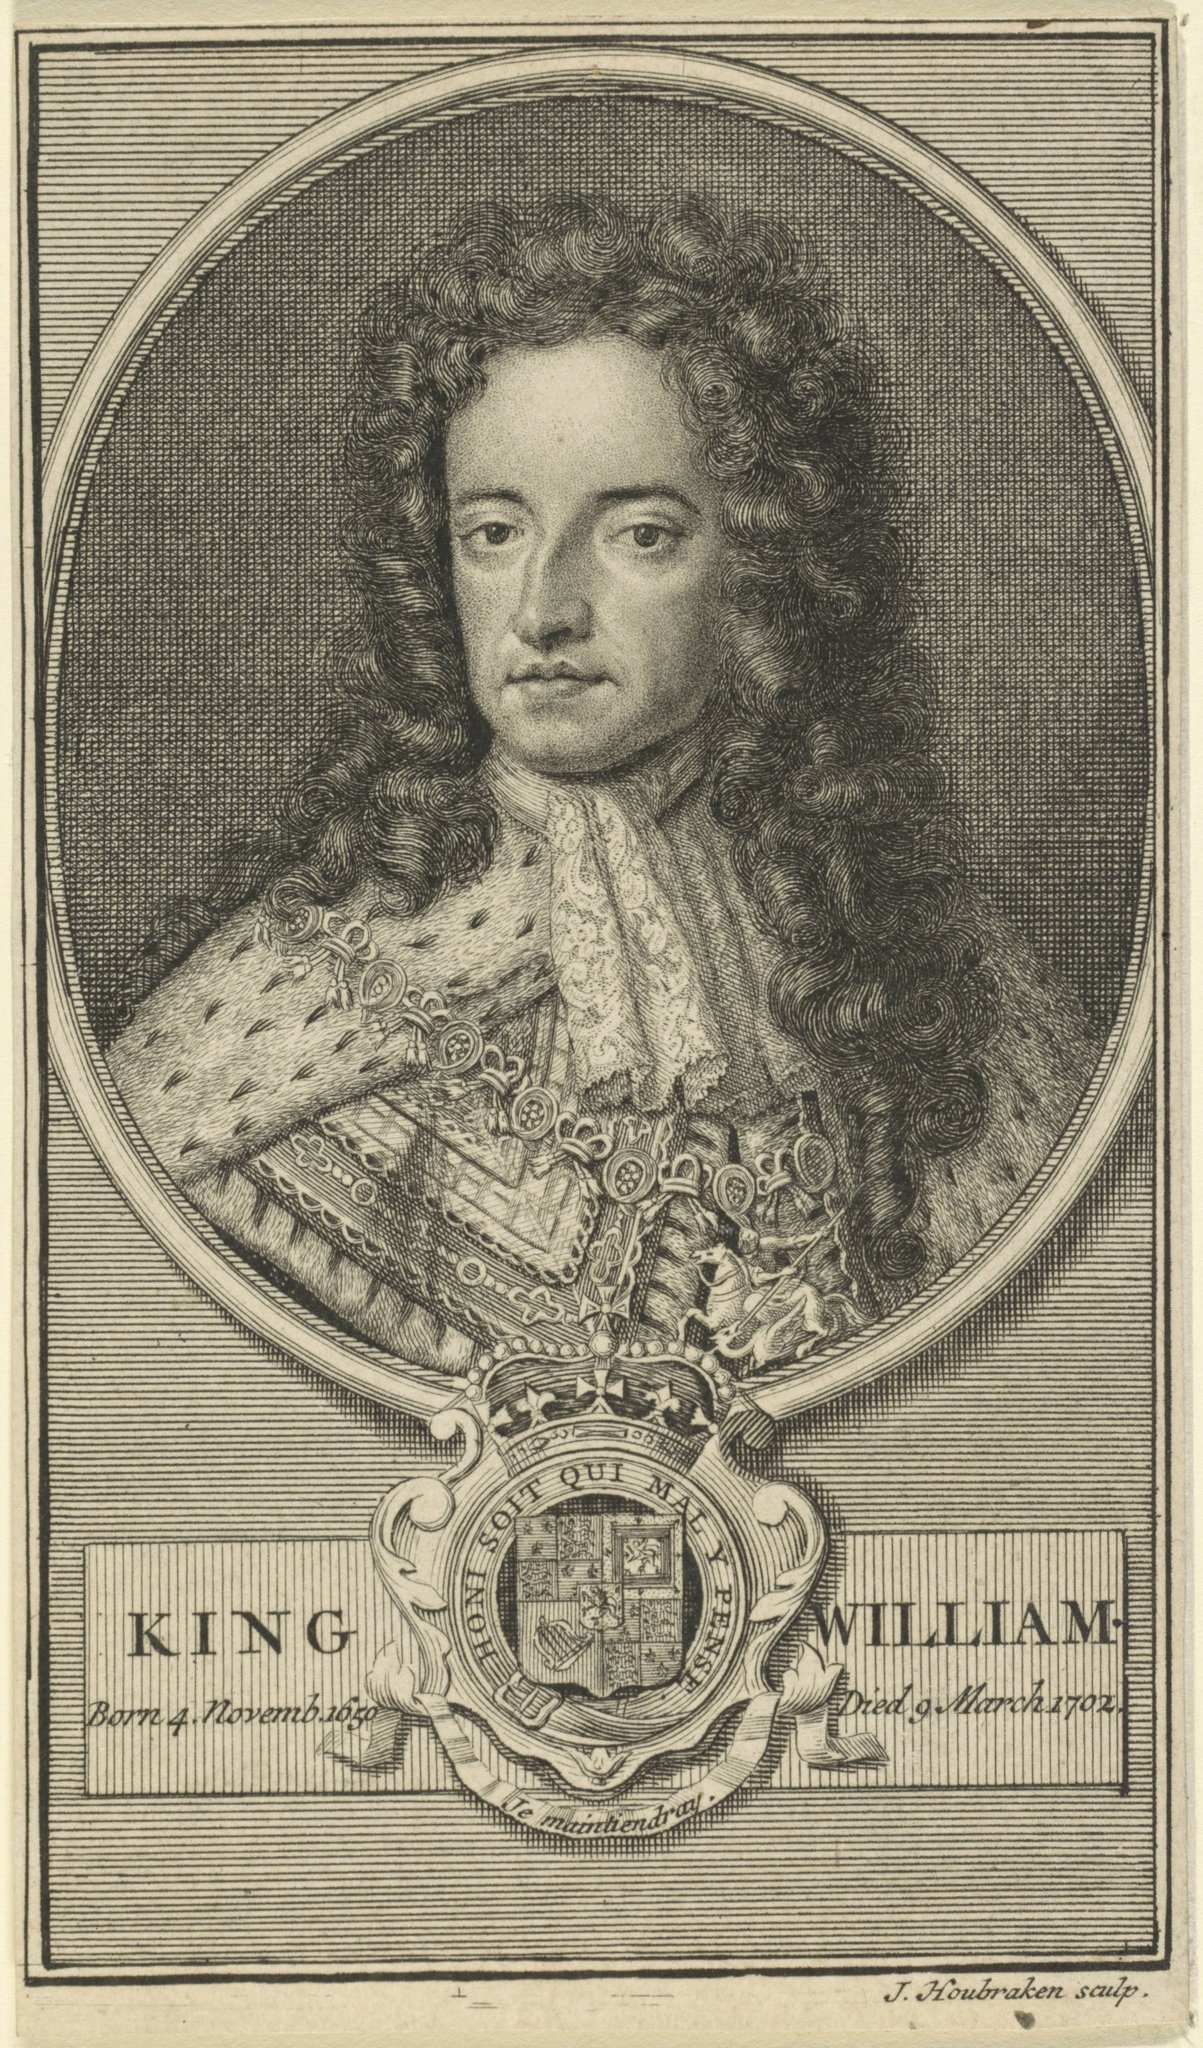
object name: print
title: Portret van Willem III, prins van Oranje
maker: jacob houbraken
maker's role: draughtsman, print maker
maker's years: 1698-1780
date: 1710-1780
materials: paper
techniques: engraving, etching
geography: amsterdam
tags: the hague, william iii (prince of orange and king of england, scotland, and ireland), knighthood order (garter) - insignia of a knighthood order, e.g.: badge, chain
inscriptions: collector's mark: Lugt 2228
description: Portret van Willem III in een ovaal. Midden onder zijn wapen met een kroon, gedecoreerd met de Kousenband en het devies van de Orde van de Kousenband. Daaronder op een banderol zijn geslachtsspreuk. In een kader zijn naam, titel, geboortedatum en sterfdatum.